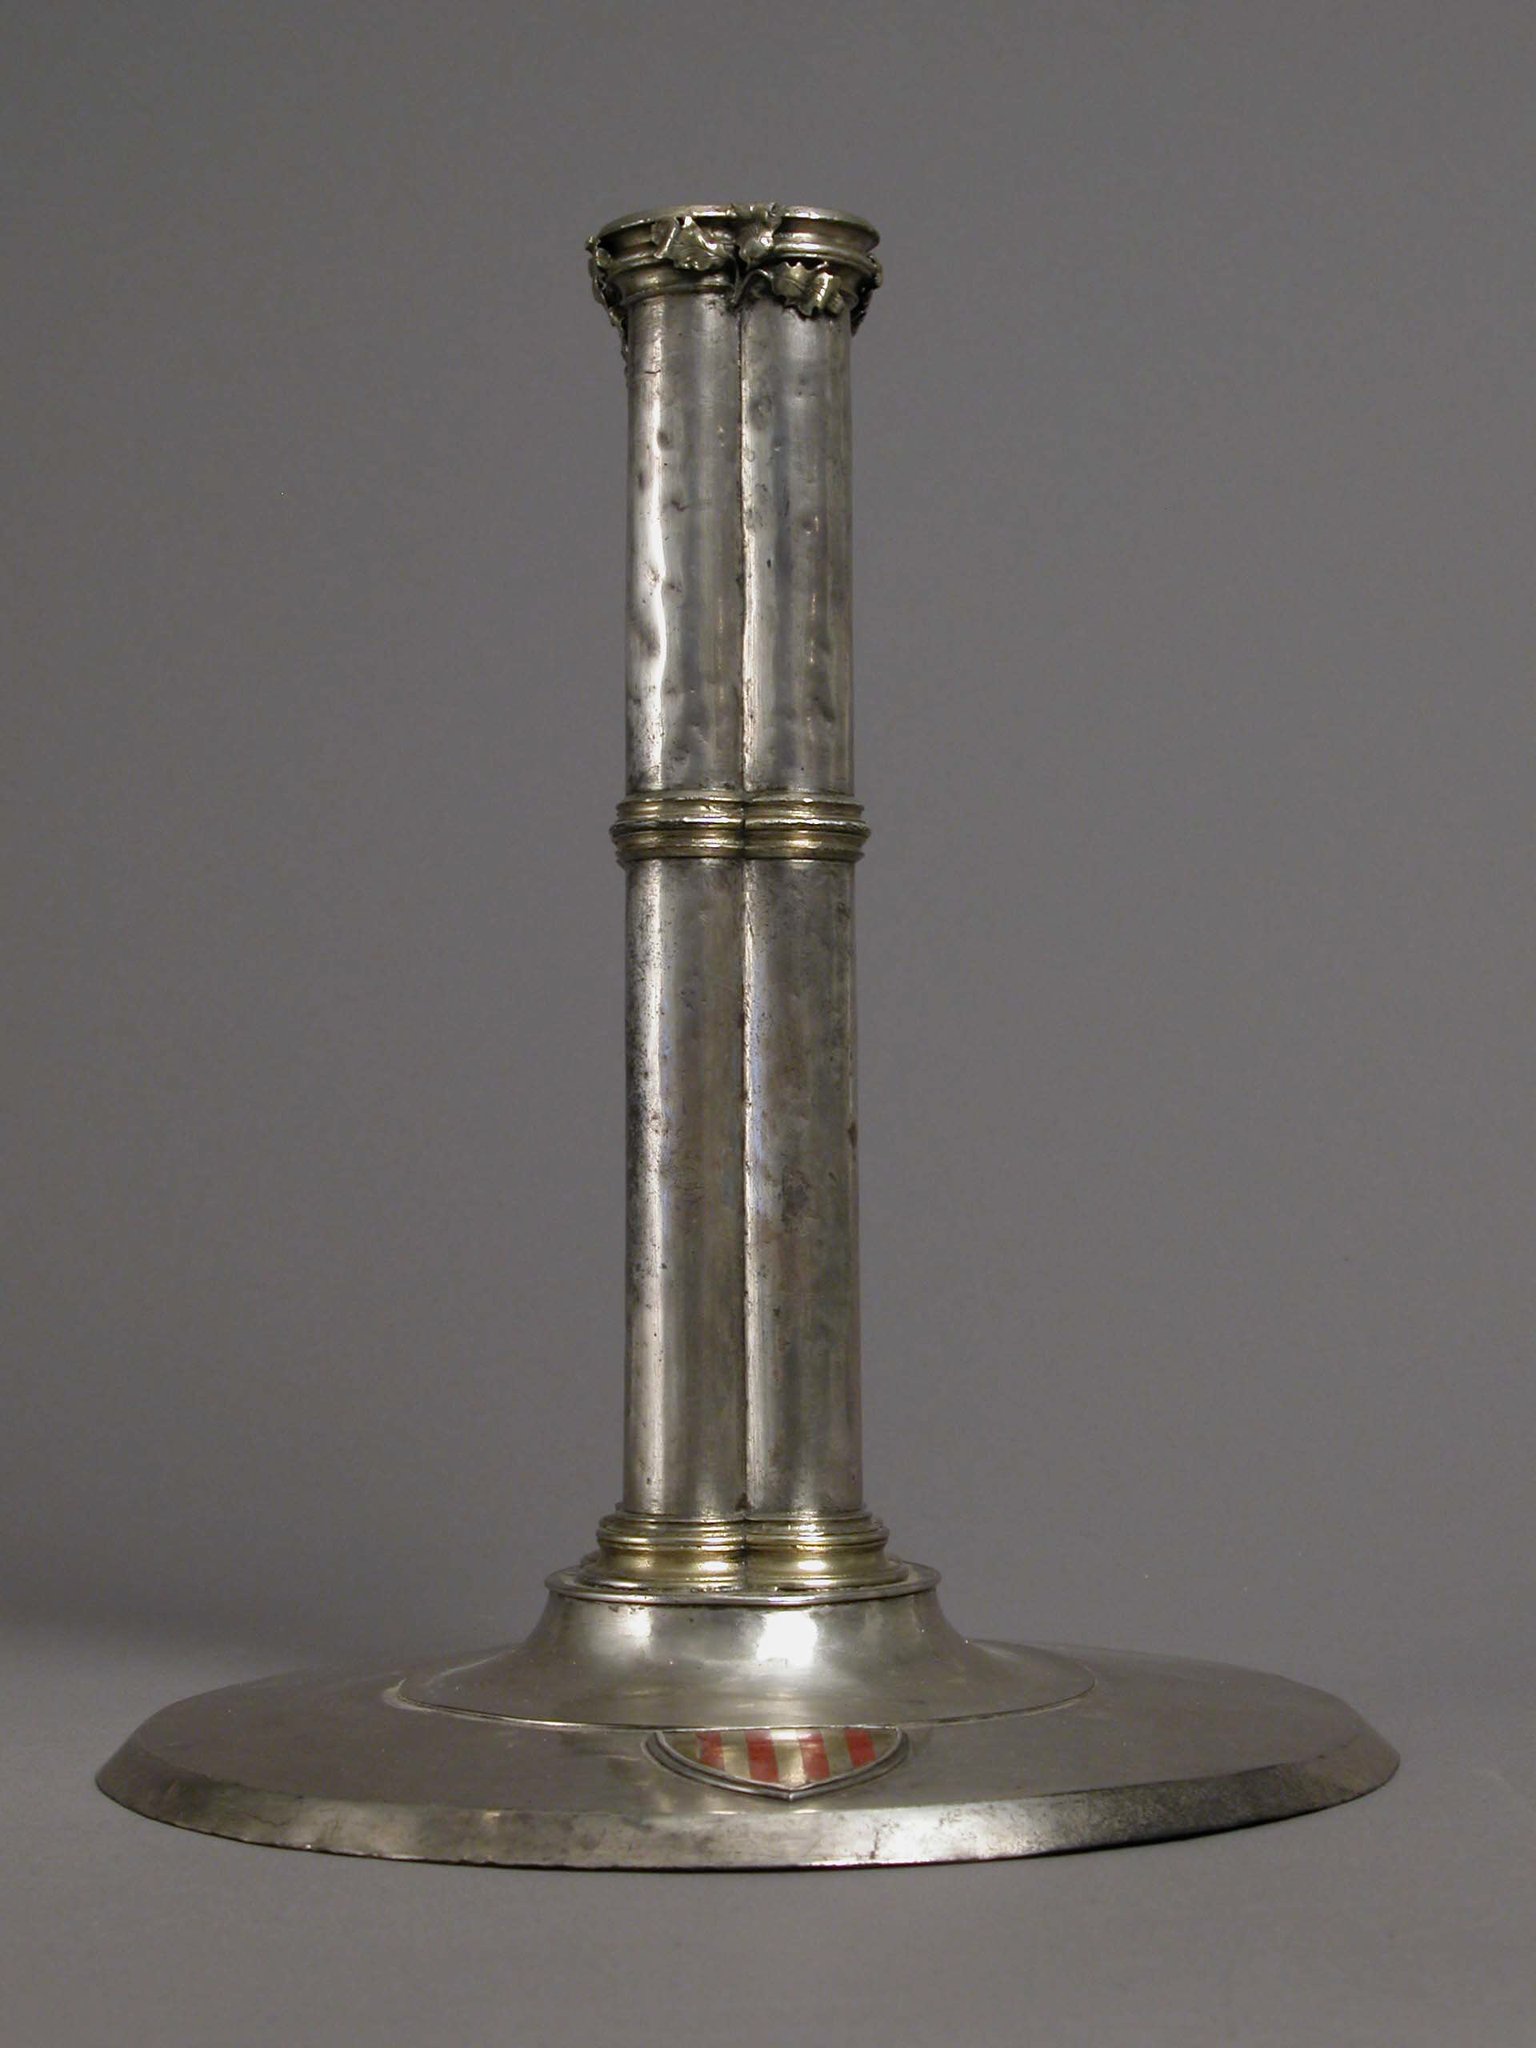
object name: candlestick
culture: spanish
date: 1401-1500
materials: enamel, silver, silver gilt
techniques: enamel